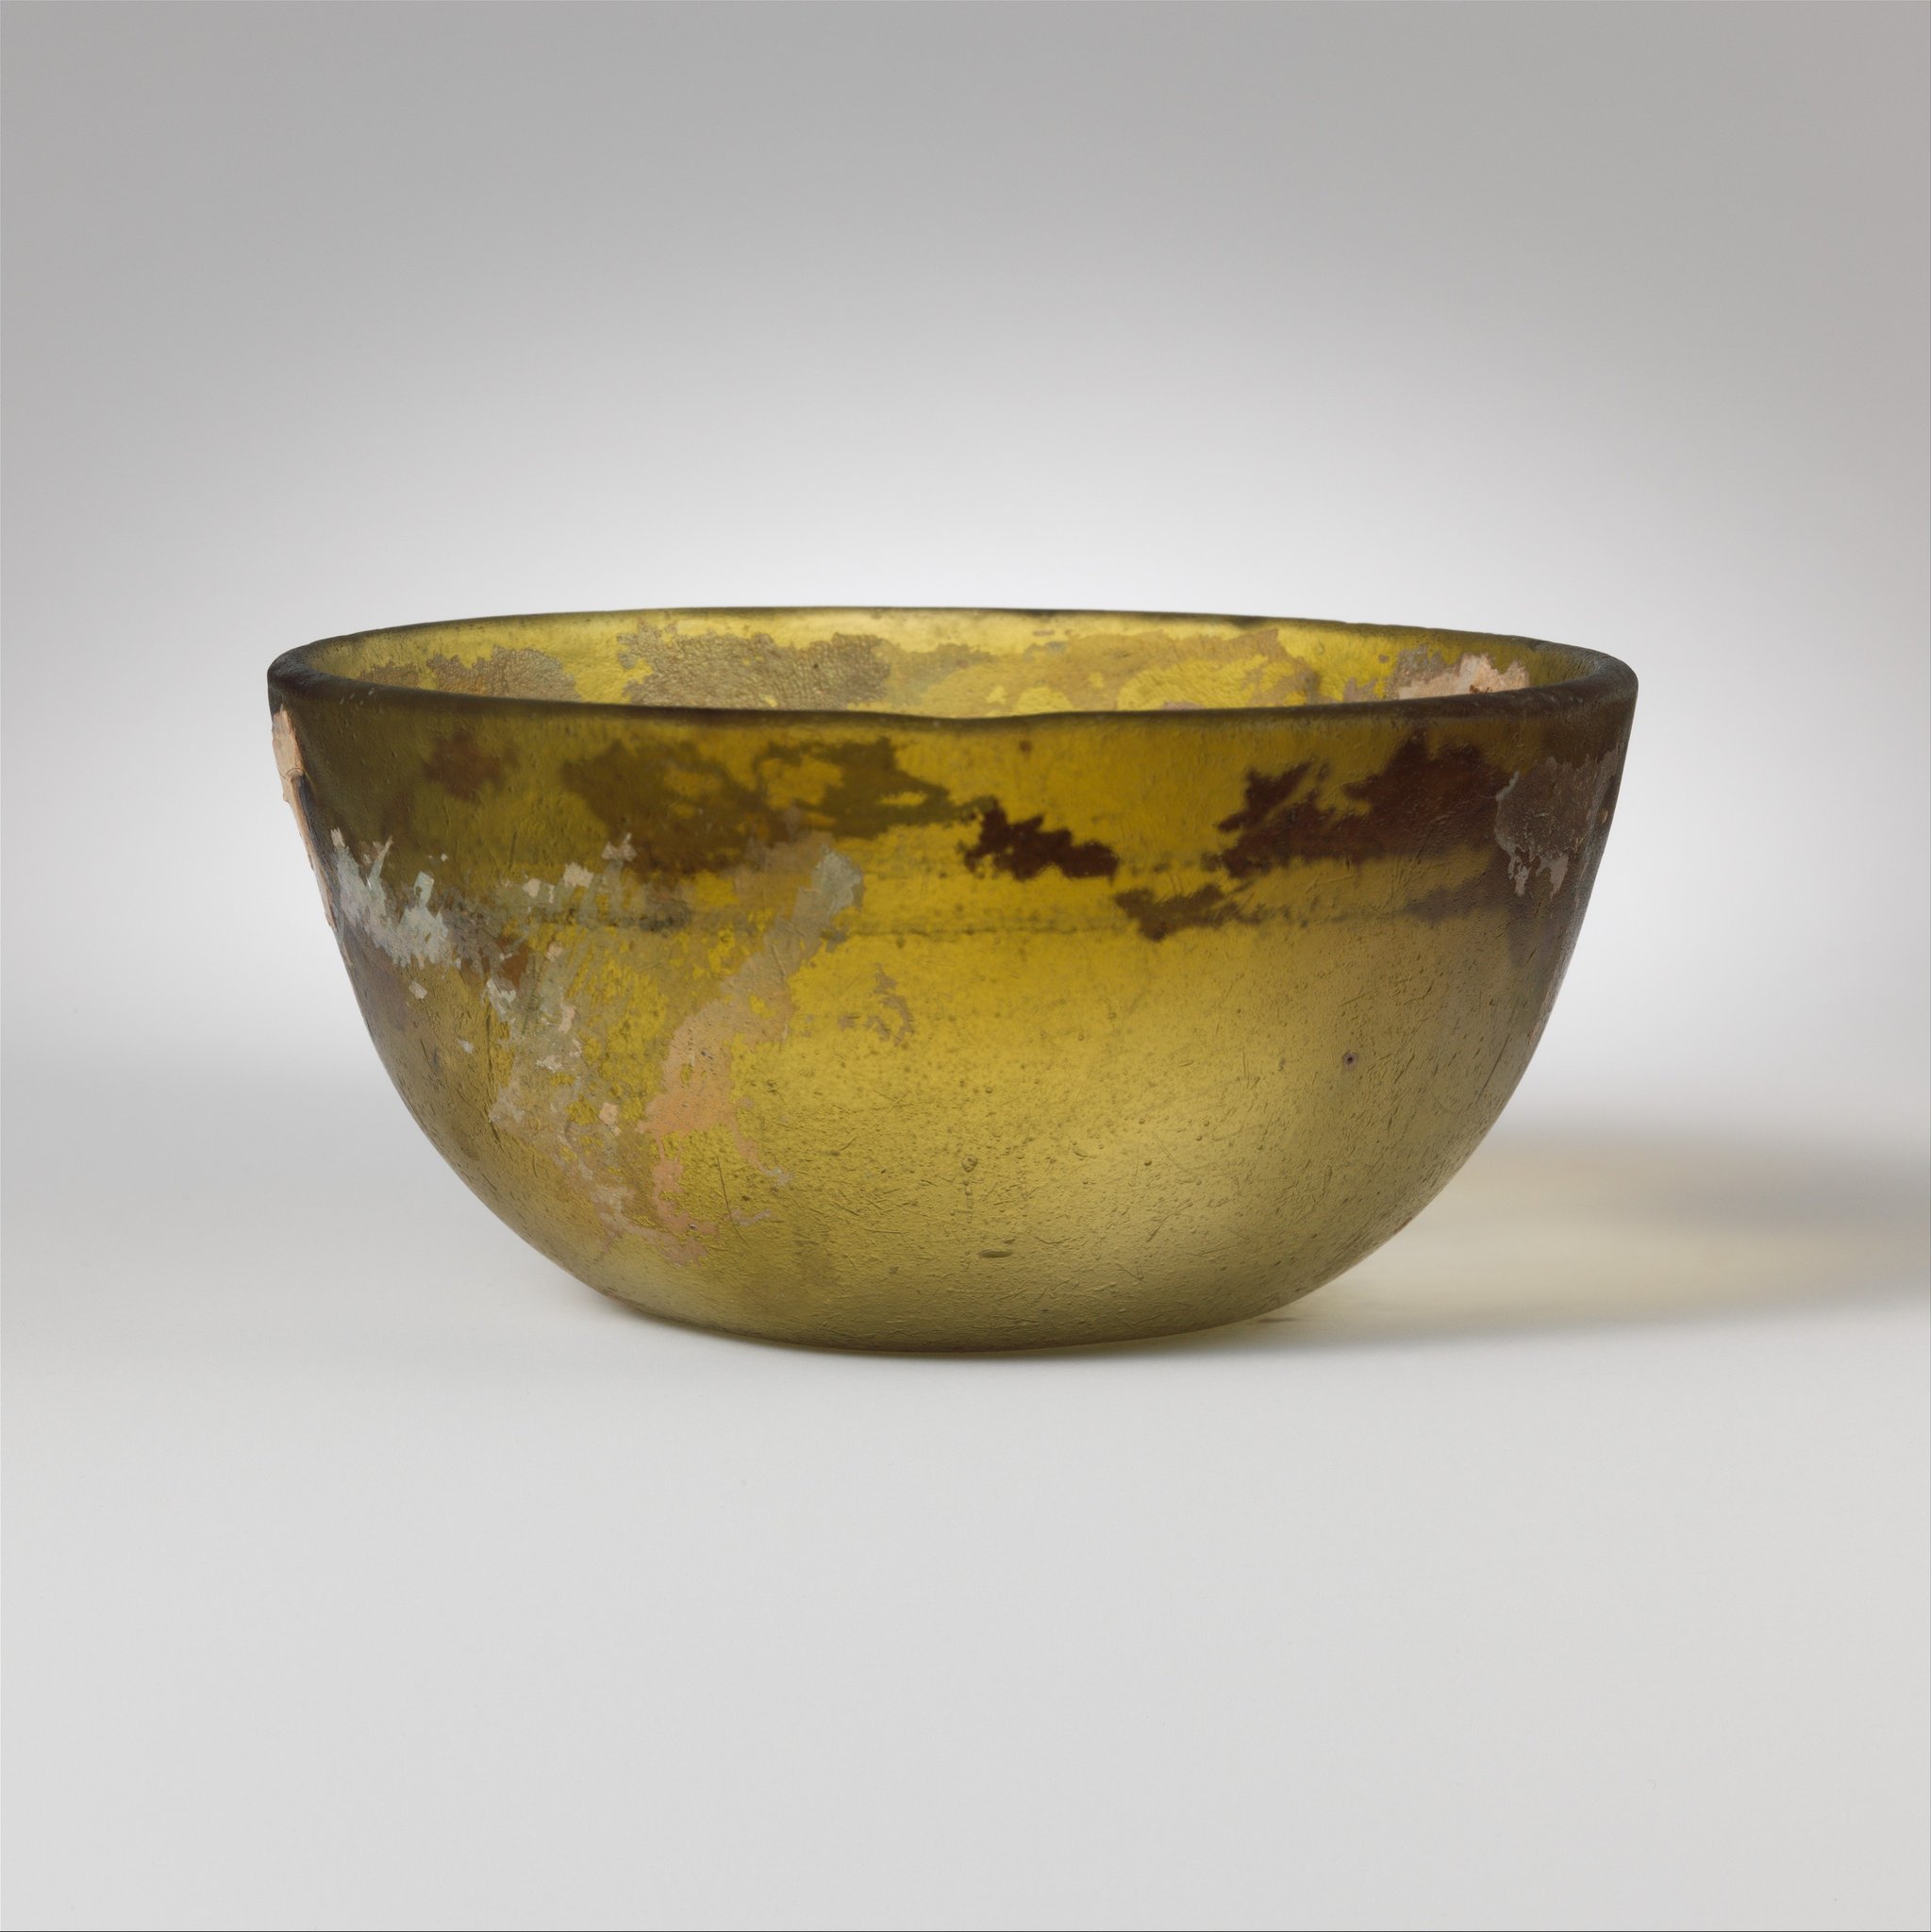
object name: bowl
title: Glass bowl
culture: roman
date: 67-100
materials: glass